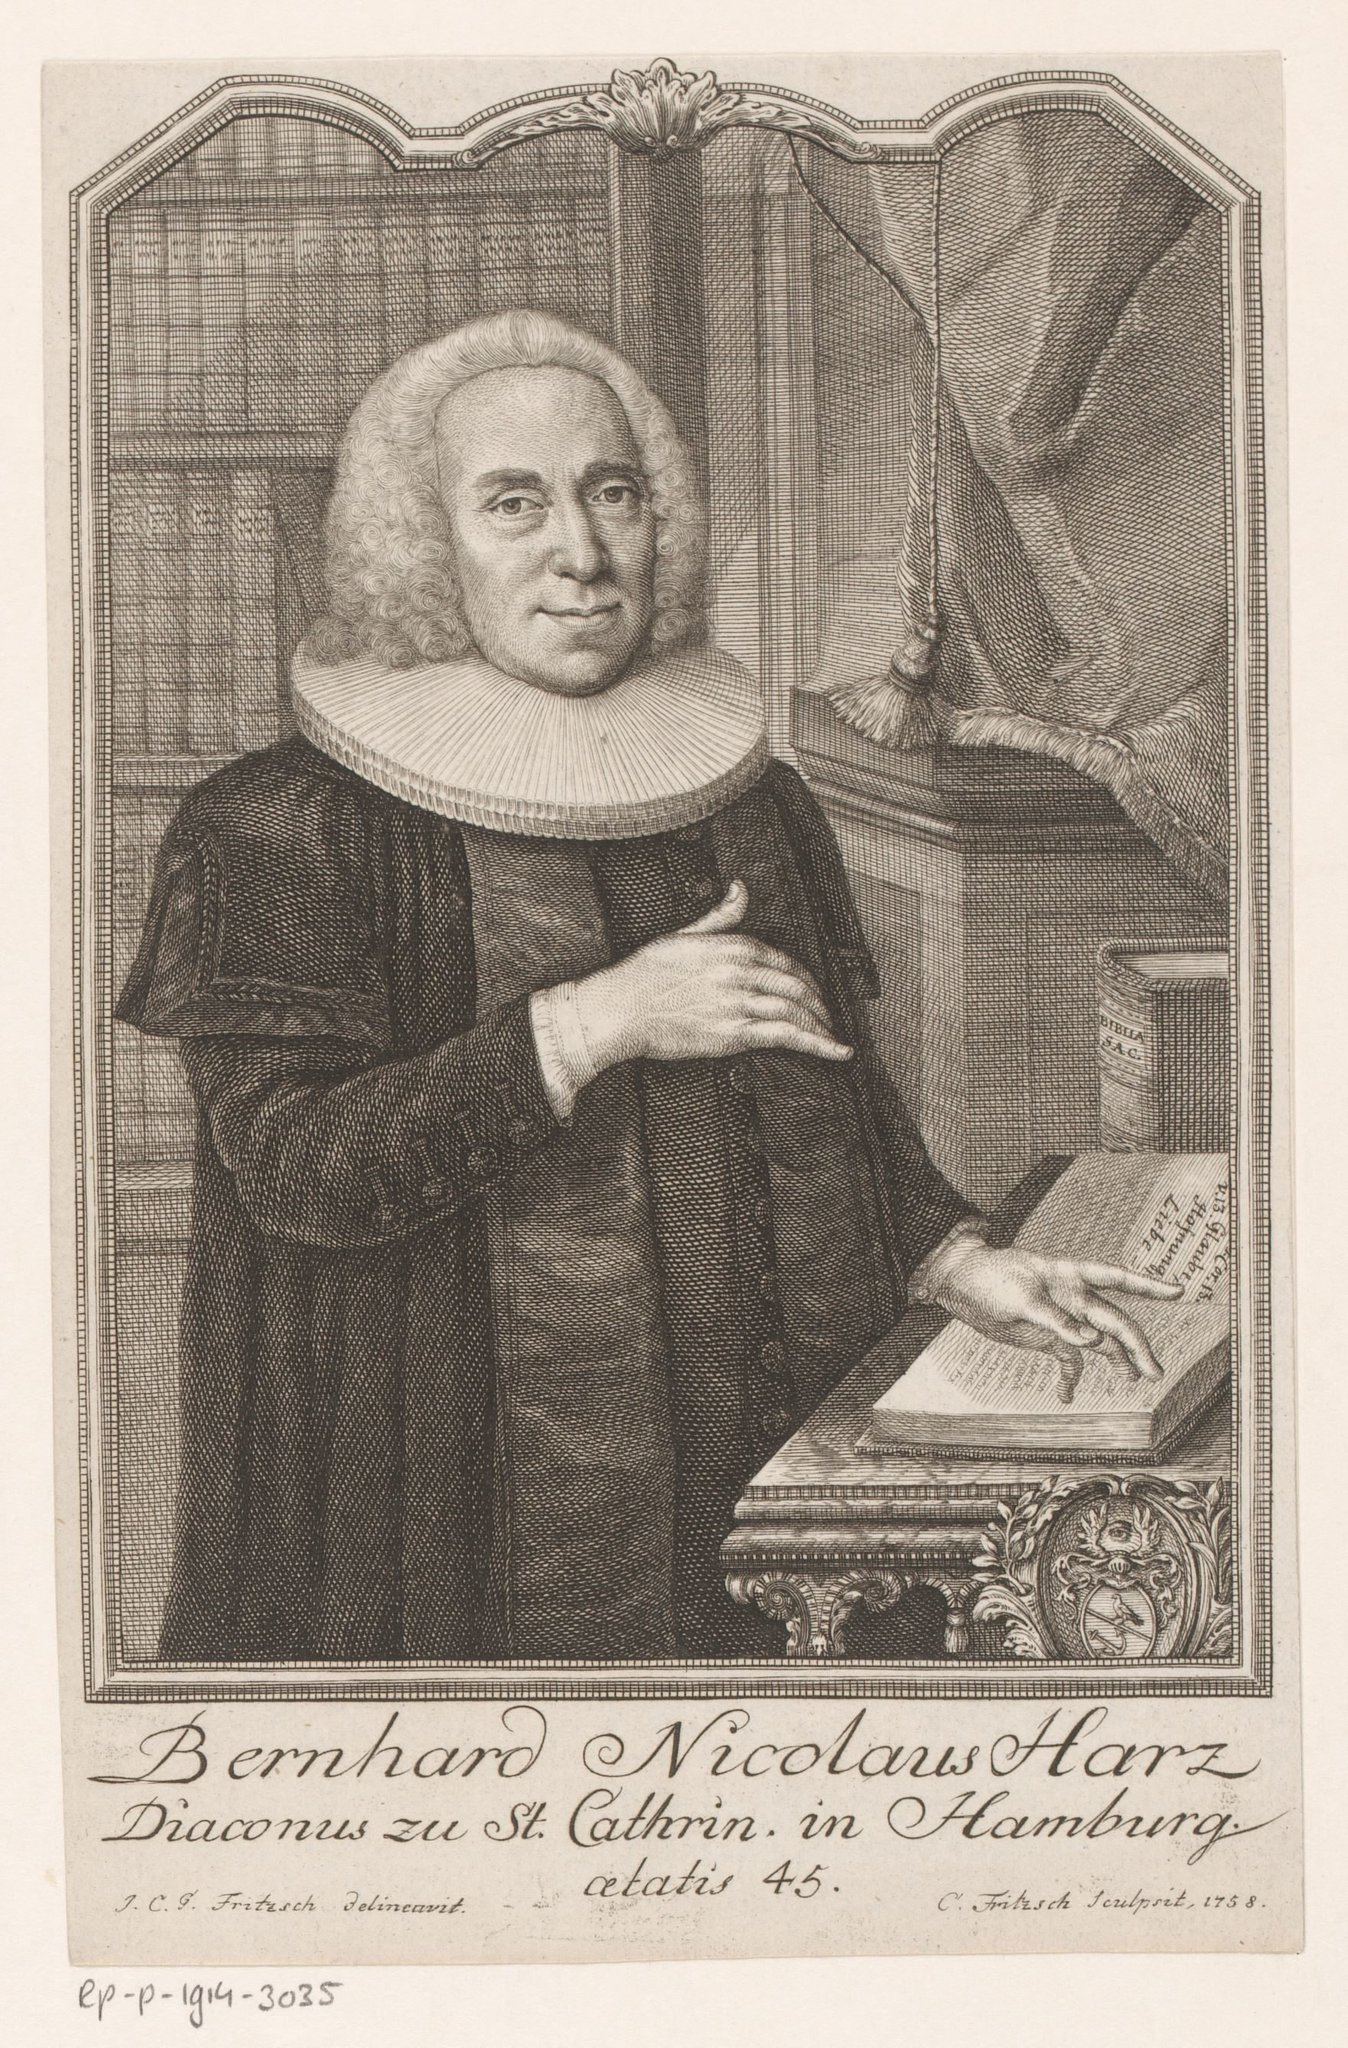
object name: print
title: Portret van Bernhard Nicolaus Harz op 45-jarige leeftijd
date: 1758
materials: paper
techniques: engraving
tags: bookshelves, historical persons, book, armorial bearing, heraldry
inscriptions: collector's mark: Lugt 2228